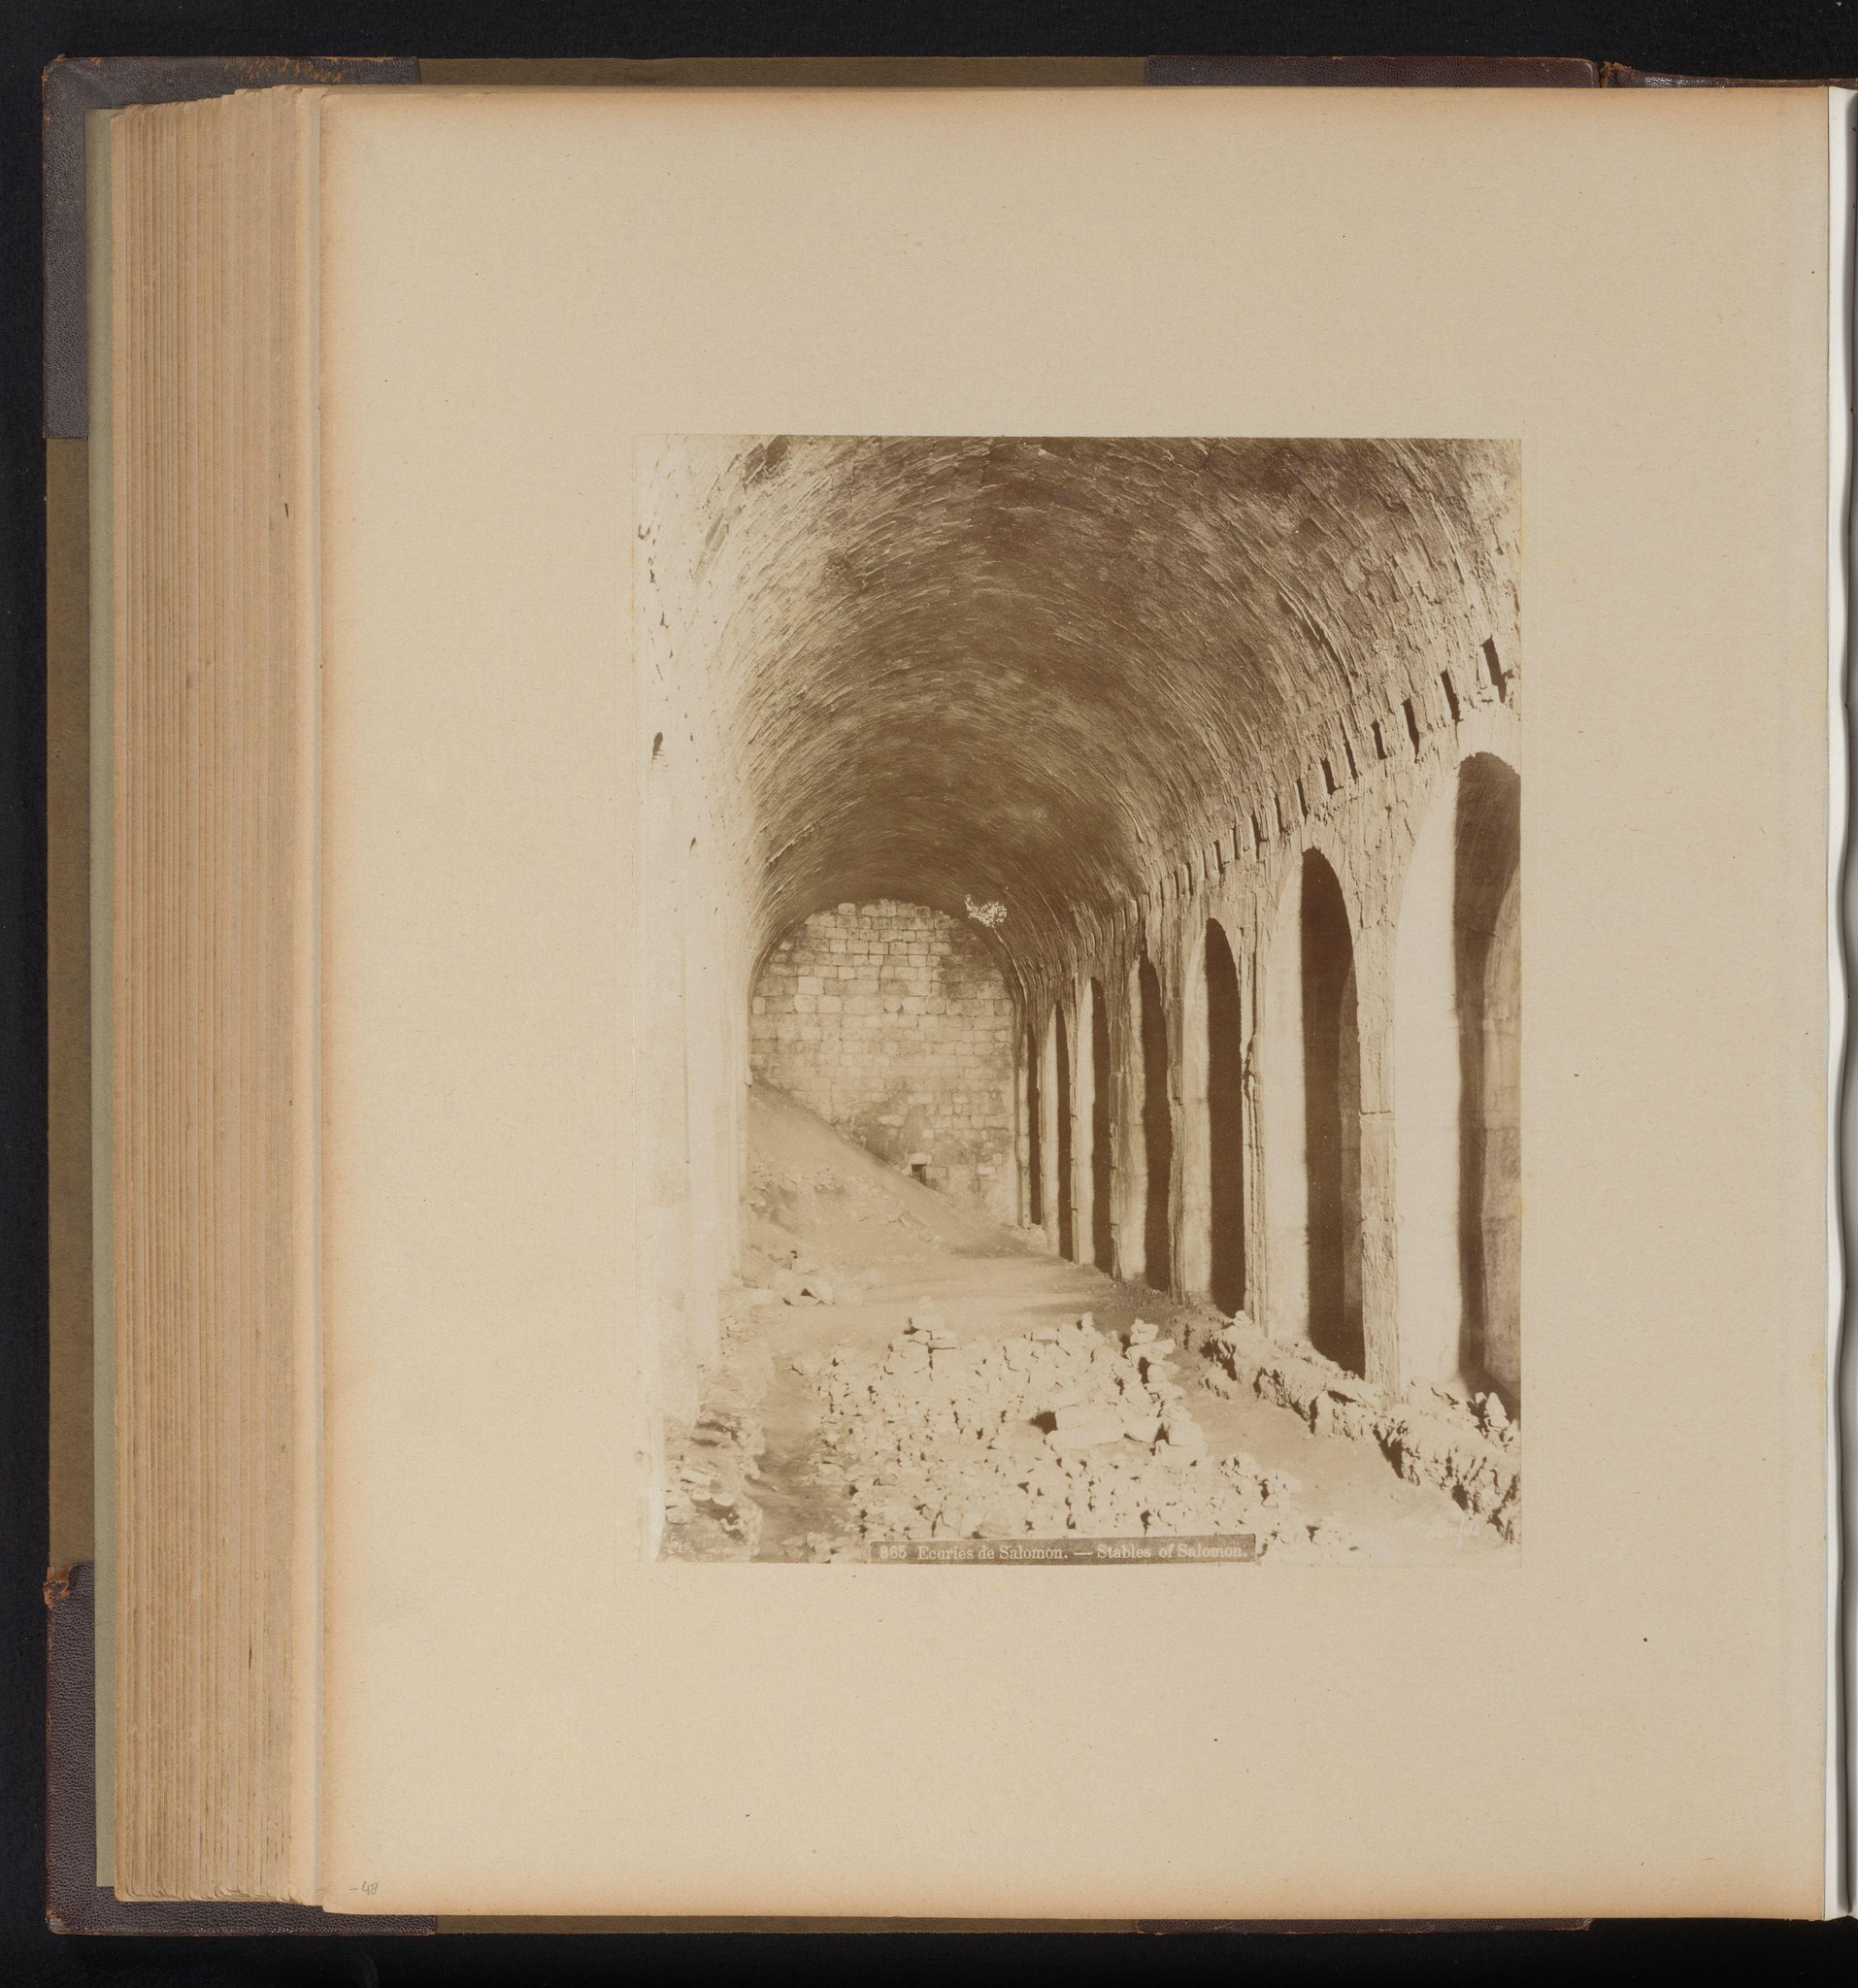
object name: photograph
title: Salomo's stallen in Jeruzalem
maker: félix bonfils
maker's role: fotograaf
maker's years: 1831-1885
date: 1867-1885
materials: paper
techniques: albumen print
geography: jerusalem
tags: basement, cellar, solomon's stables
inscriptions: number: ‘865’